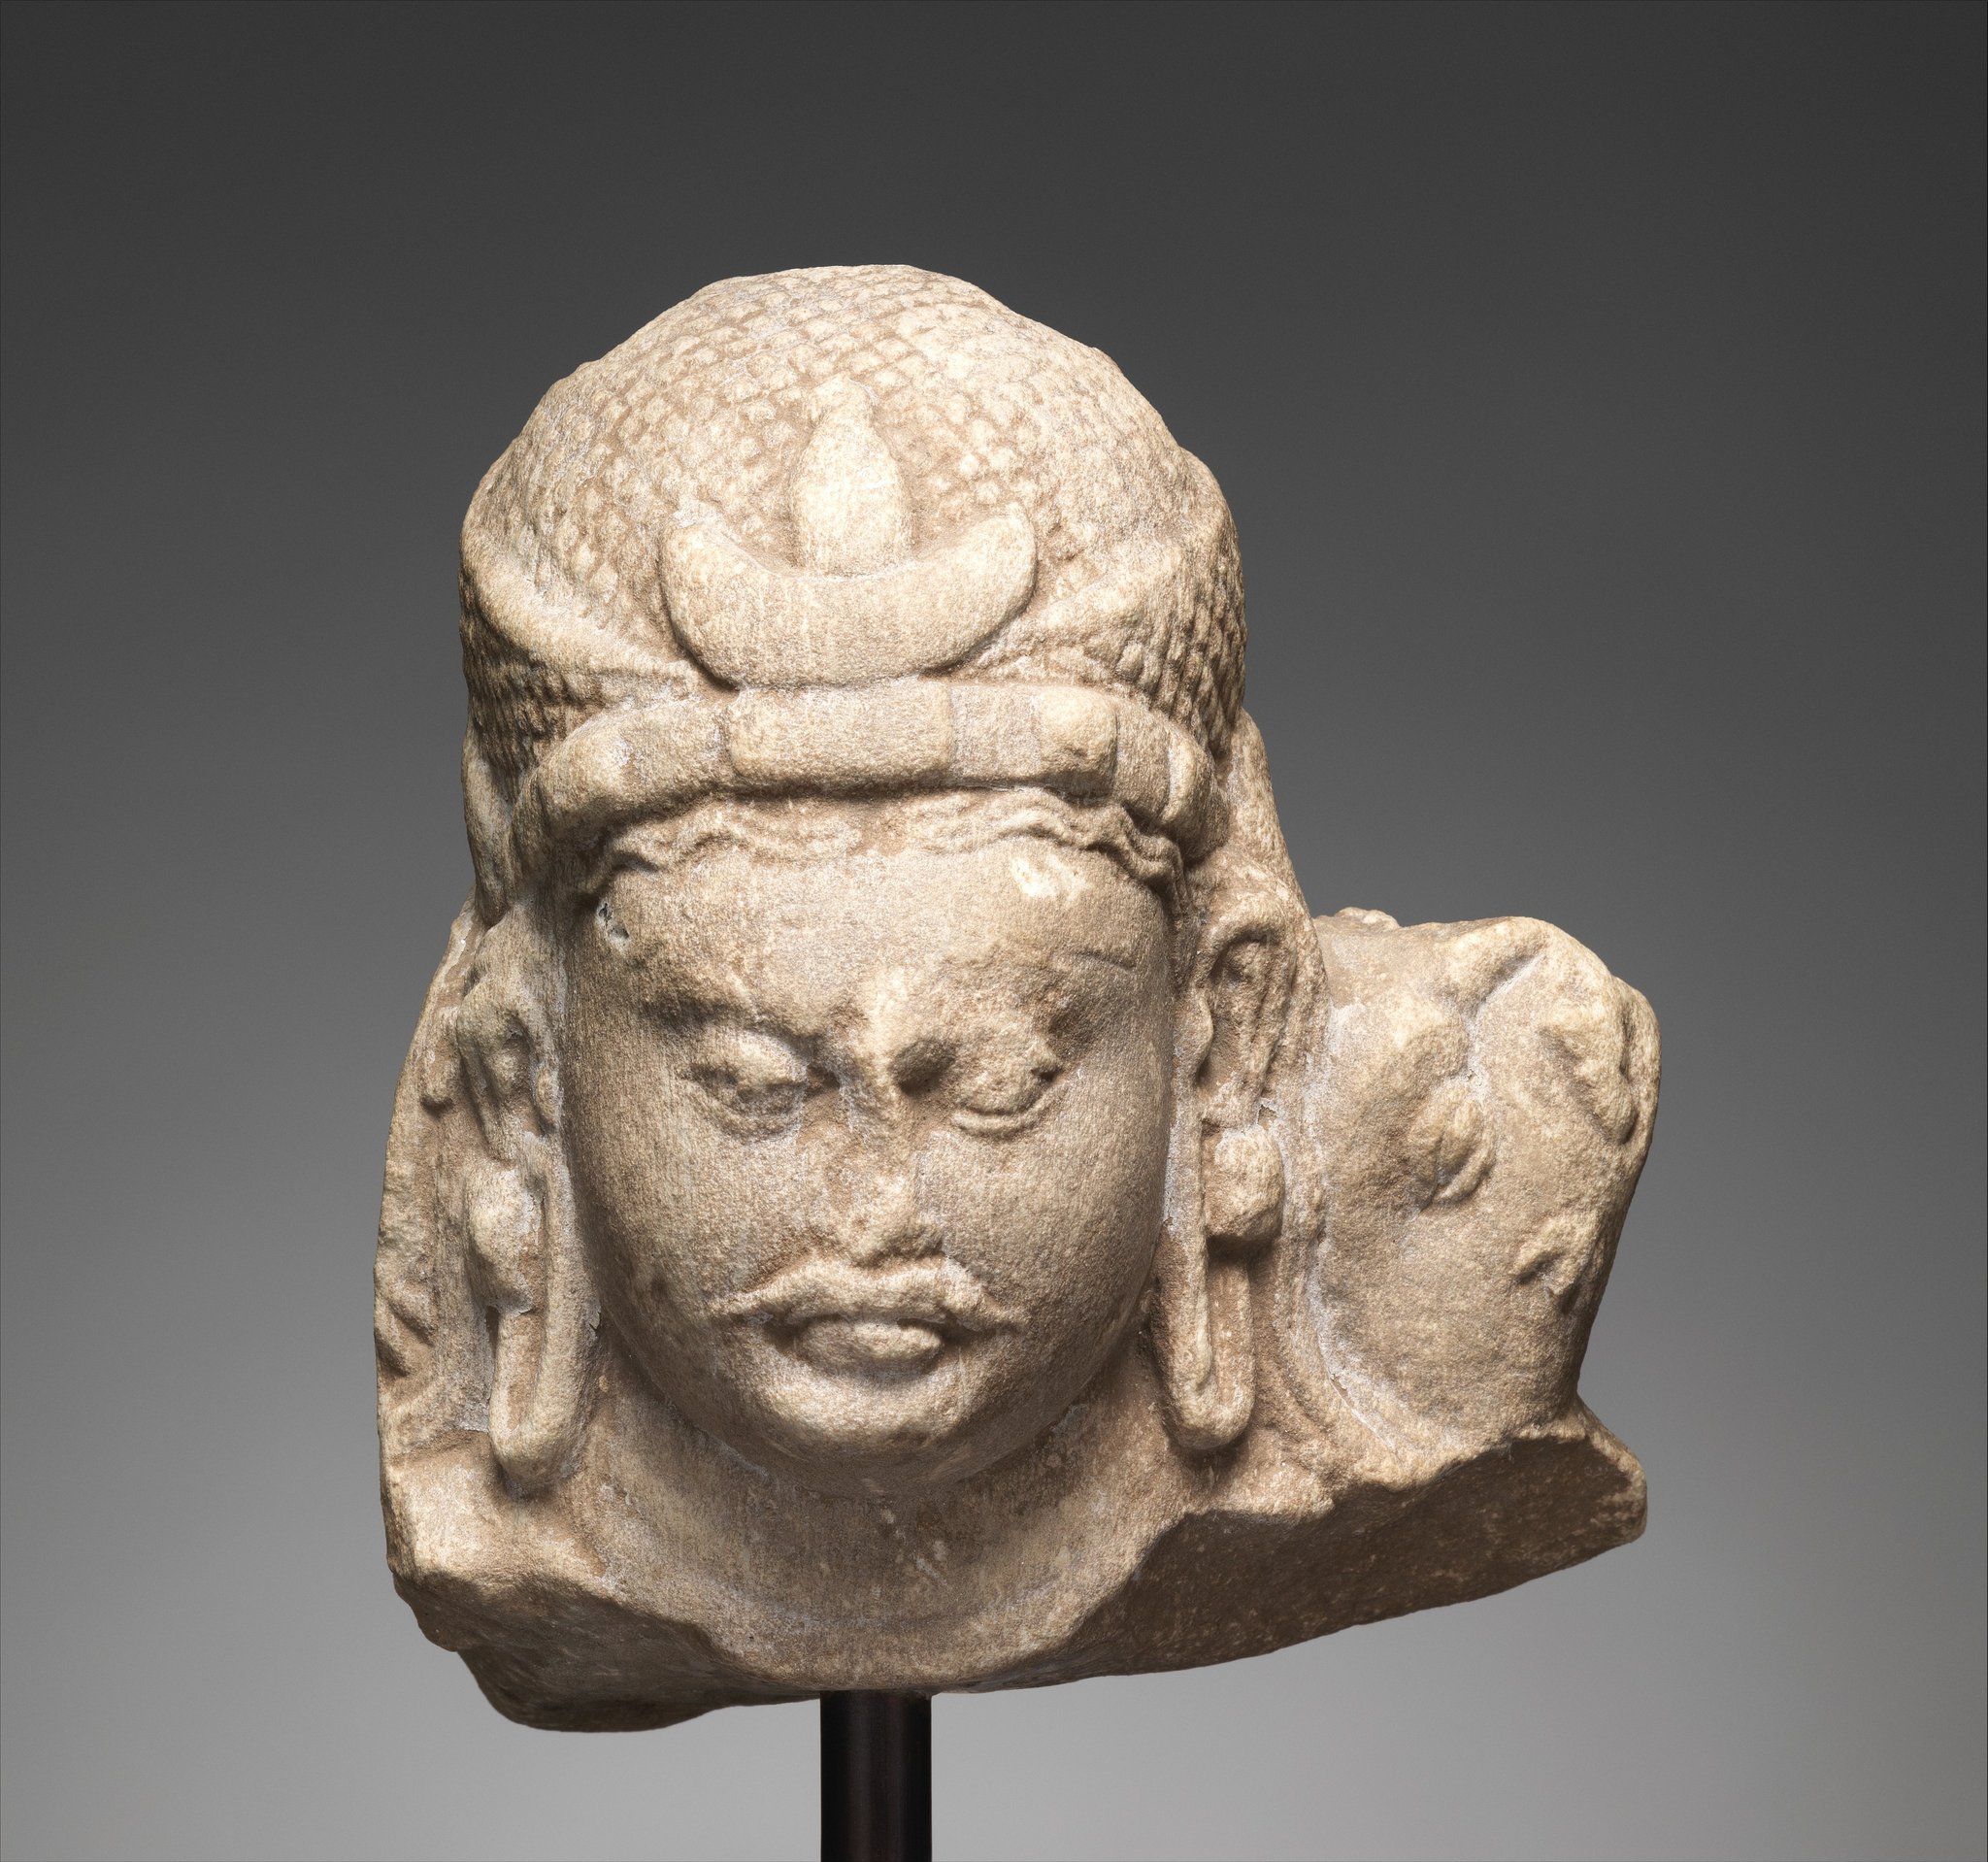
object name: head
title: Head of Vaitunkta Vishnu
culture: pakistani, brahmanical post-gupta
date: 501-600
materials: mineral, stone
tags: gandhara,vishnu,hinduism